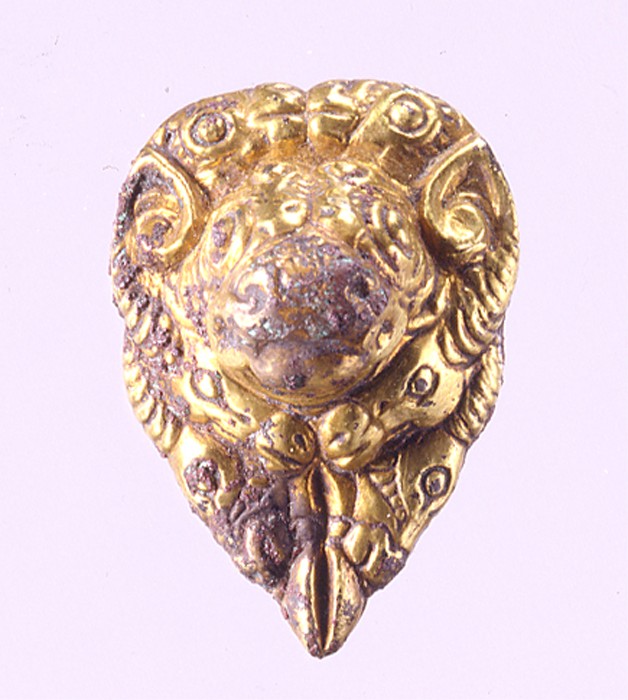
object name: harness fitting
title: Harness Fitting with Zoomorphic Motif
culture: north chinese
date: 300-201 BCE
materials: bronze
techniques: gilding